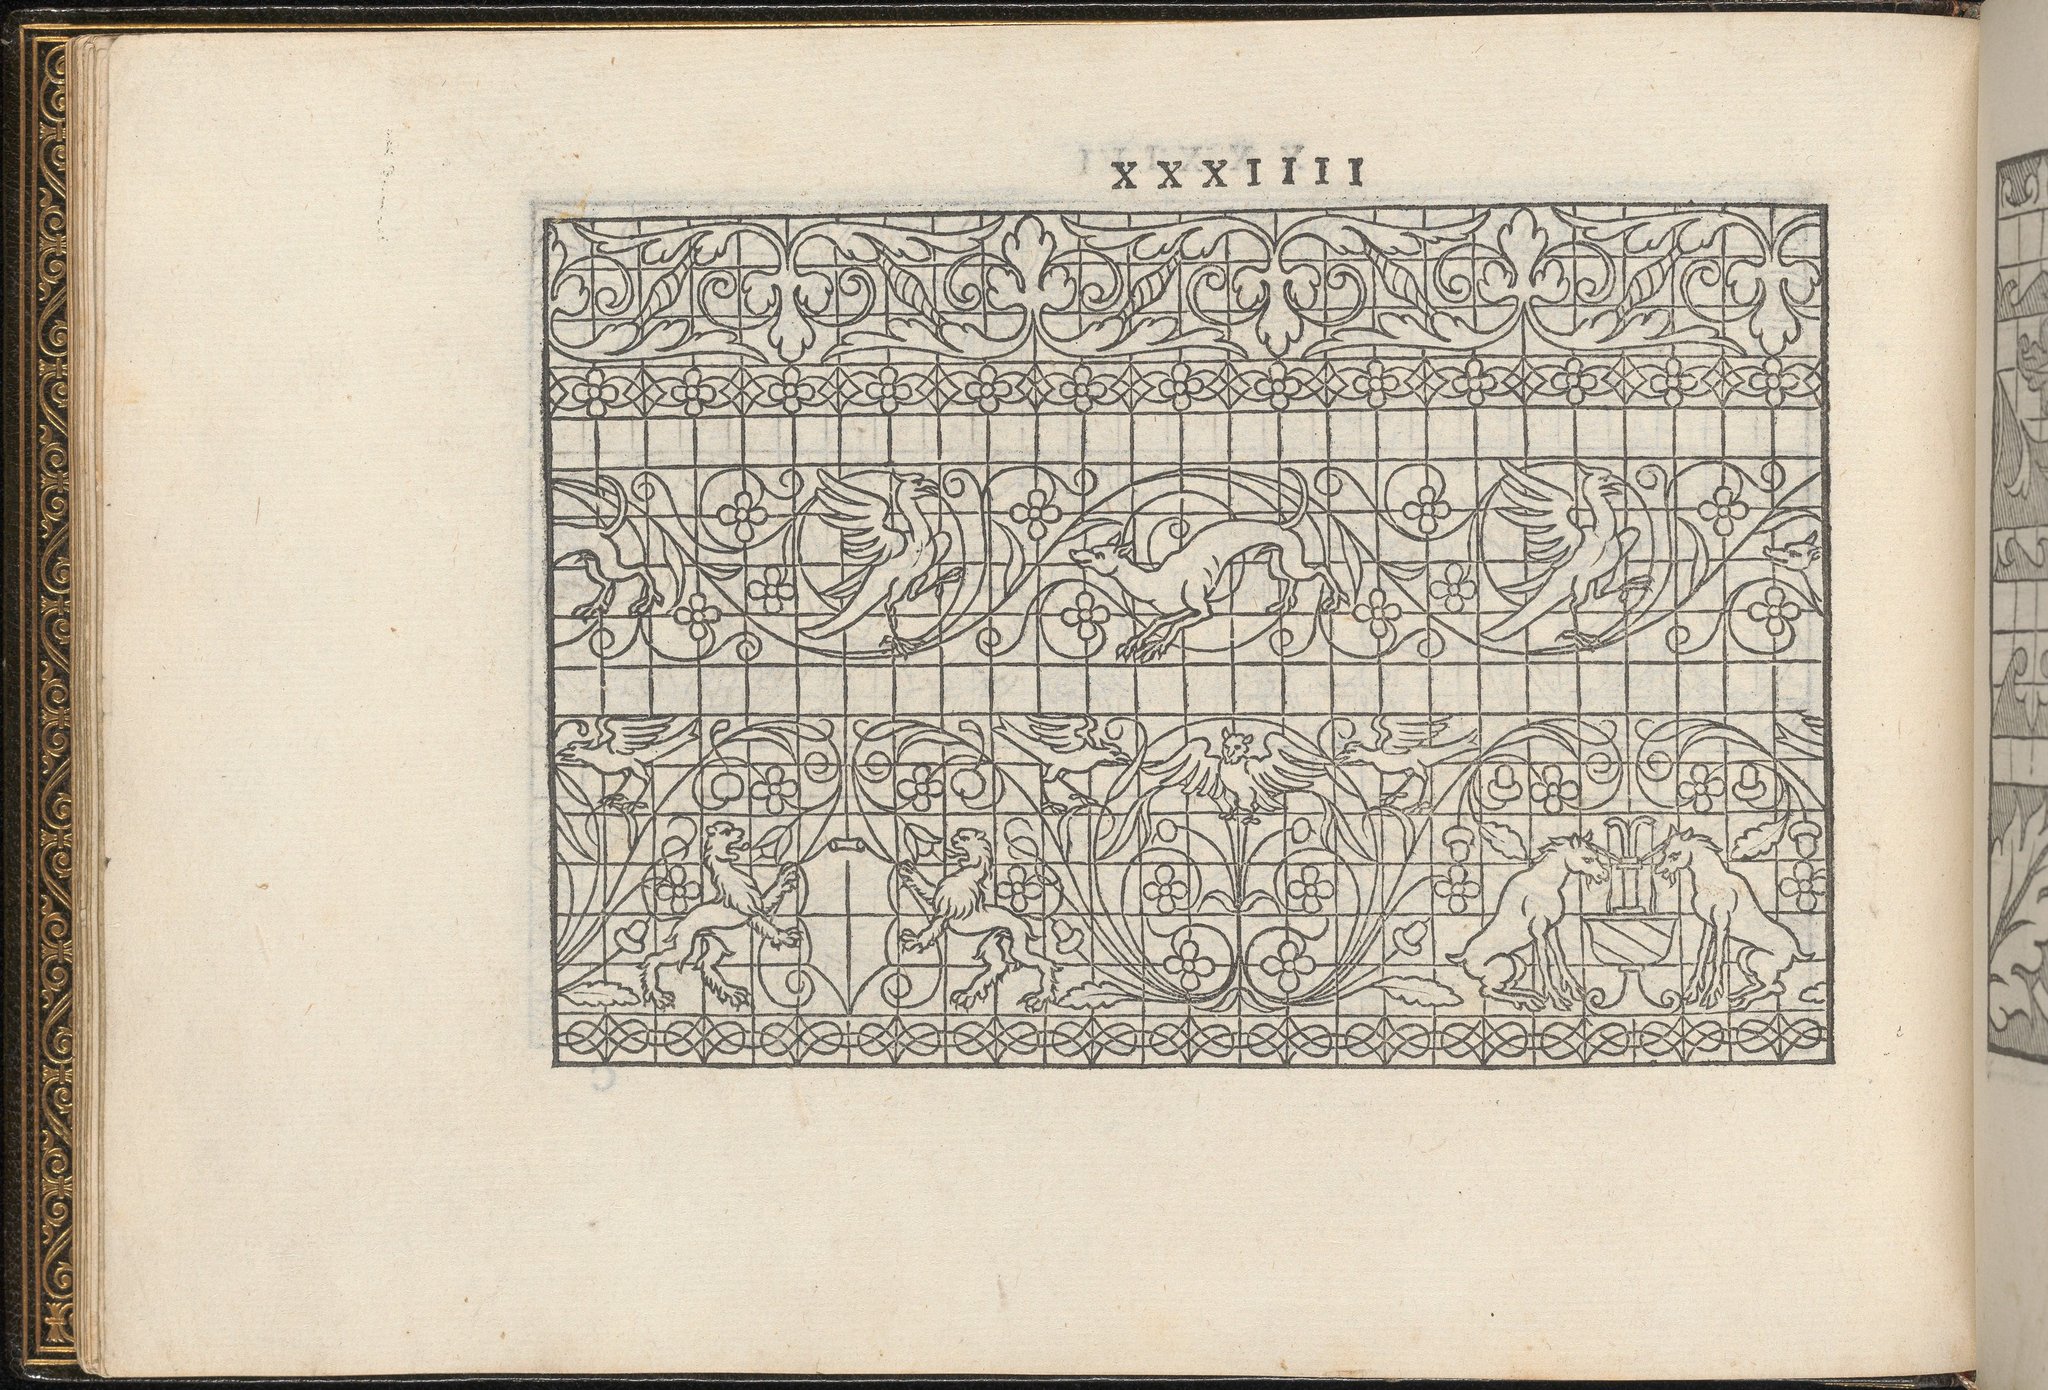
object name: book print ornament architecture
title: La Vera Perfettione del Disegno di varie sorti di recami, page 17 (verso)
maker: giovanni ostaus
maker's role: publisher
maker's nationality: italian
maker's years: 1507-1607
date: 1567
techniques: woodcut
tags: ornament